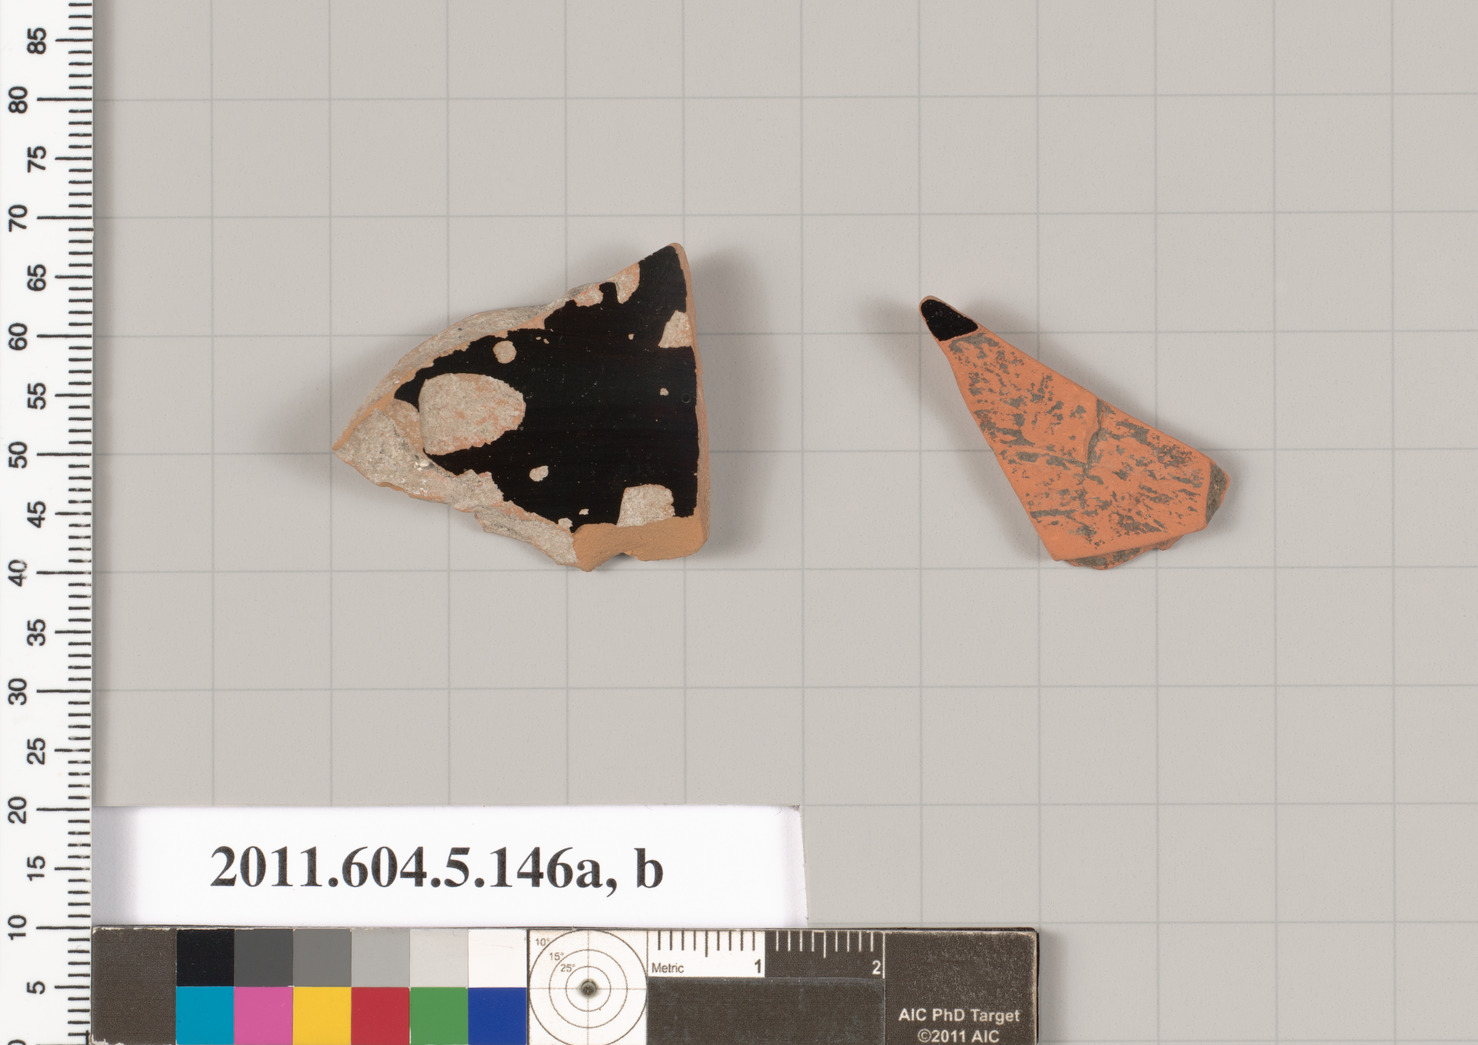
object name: kylix fragment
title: Terracotta fragments of kylikes (drinking cups)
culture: greek, attic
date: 600-401 BCE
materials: terracotta